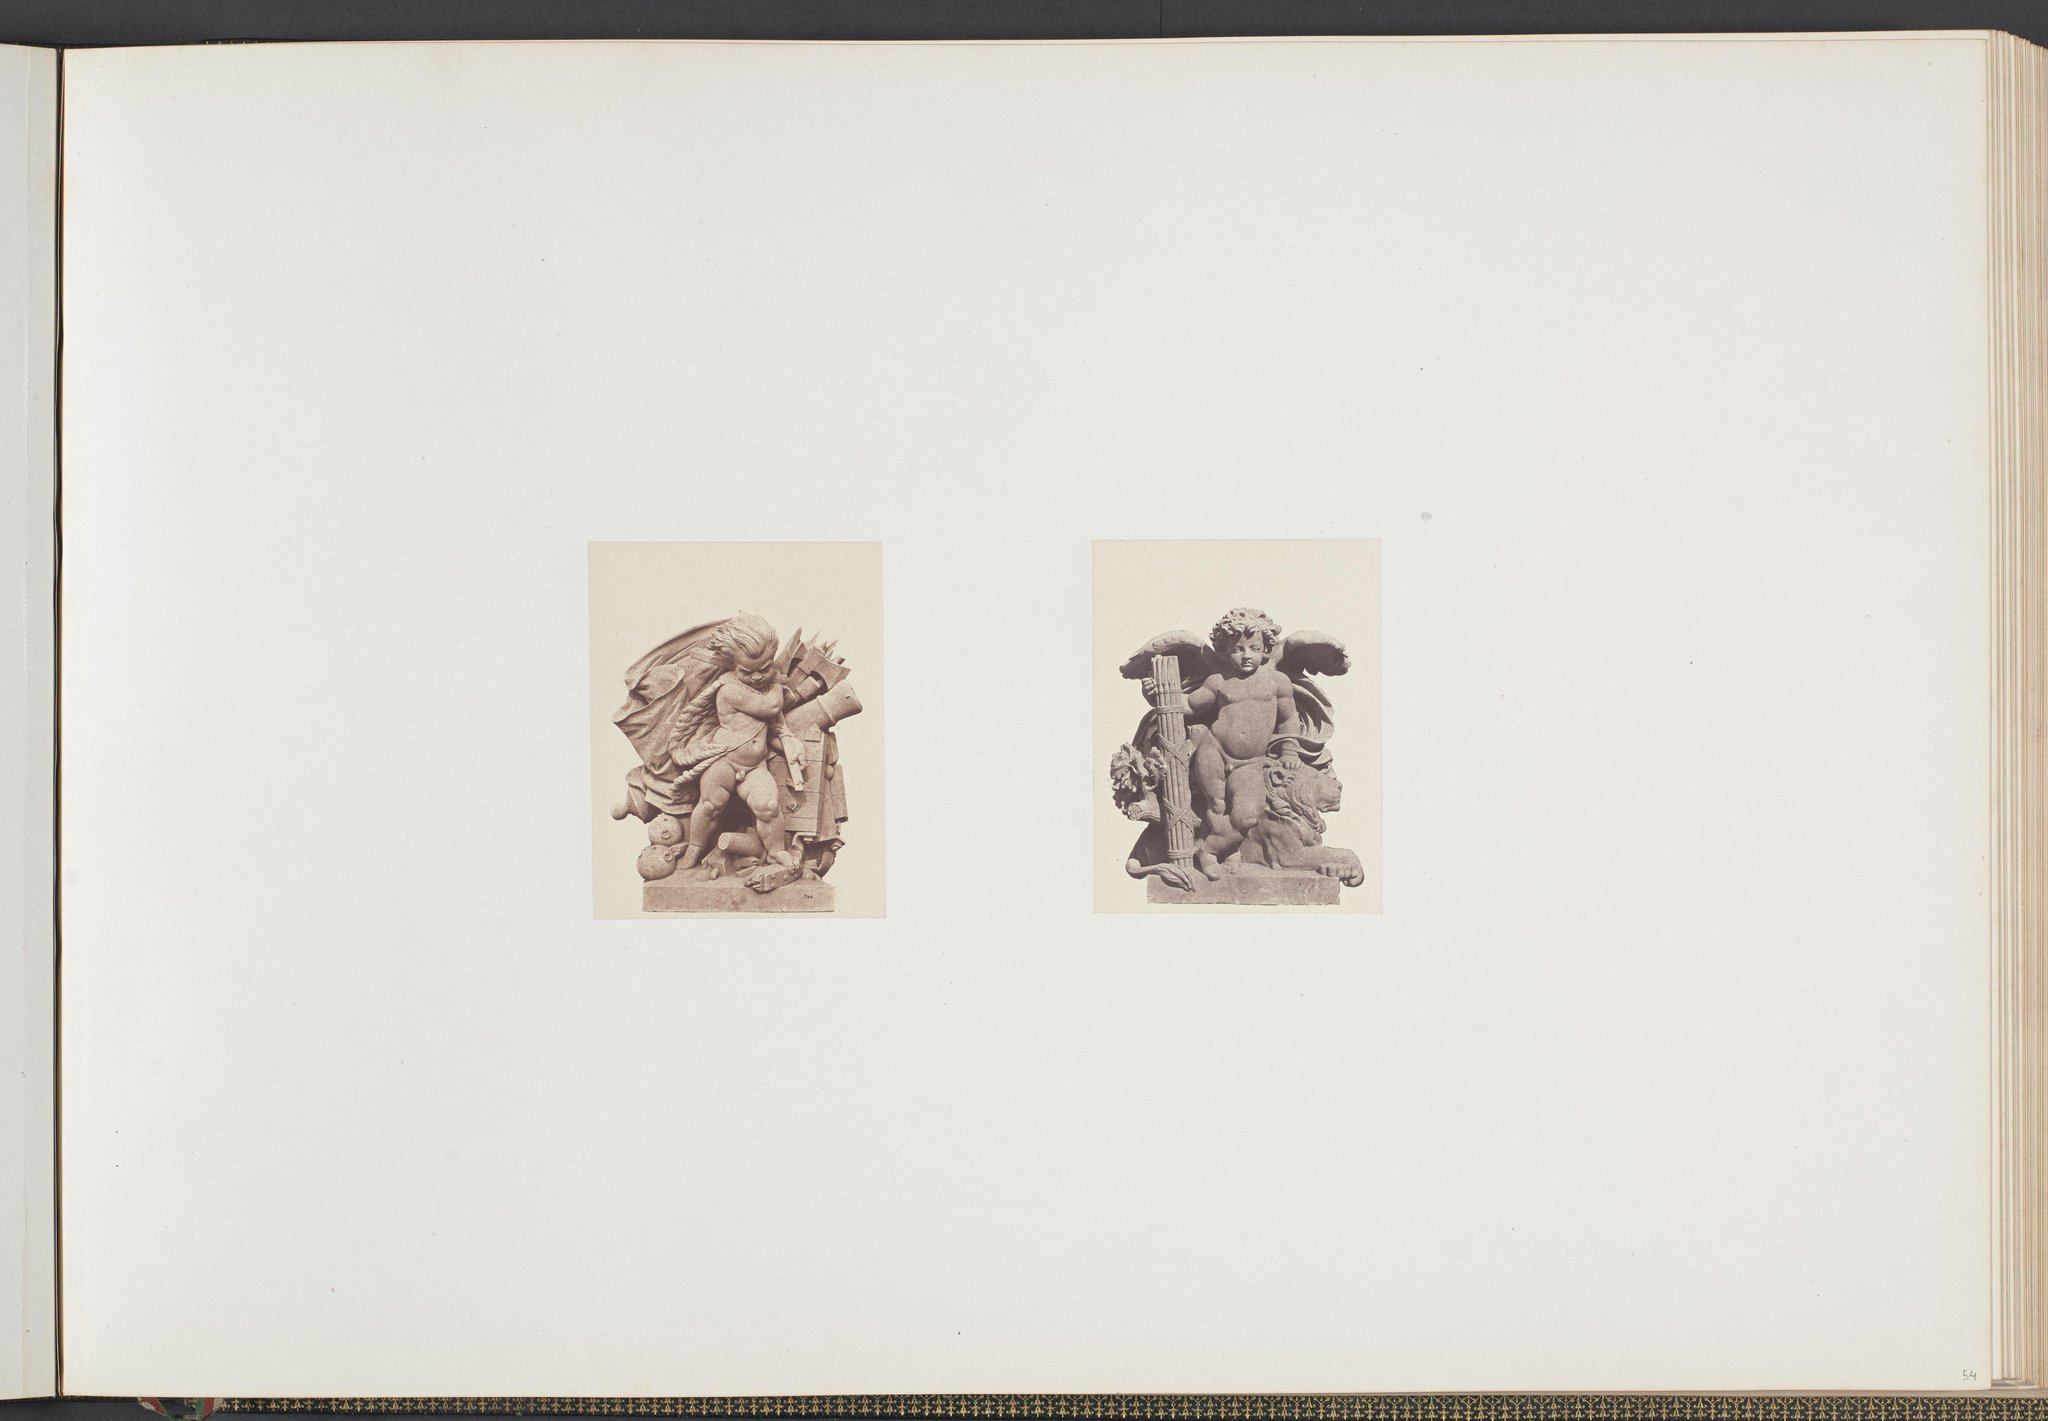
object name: photograph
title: Gipsmodellen voor beeldhouwwerken op het Palais du Louvre: links "Les Combats" door Jean-François Soitoux en rechts "La Force" door Armand Toussaint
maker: édouard denis baldus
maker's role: fotograaf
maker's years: 1813-1889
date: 1855-1857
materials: paper, photographic support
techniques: salted paper print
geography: paris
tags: piece of sculpture, reproduction of a piece of sculpture, permanent exhibition, museum, paris, tuileries palace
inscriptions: number: ‘794 (links)’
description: Onderdeel van Réunion des Tuileries au Louvre 1852-1857, album 2.